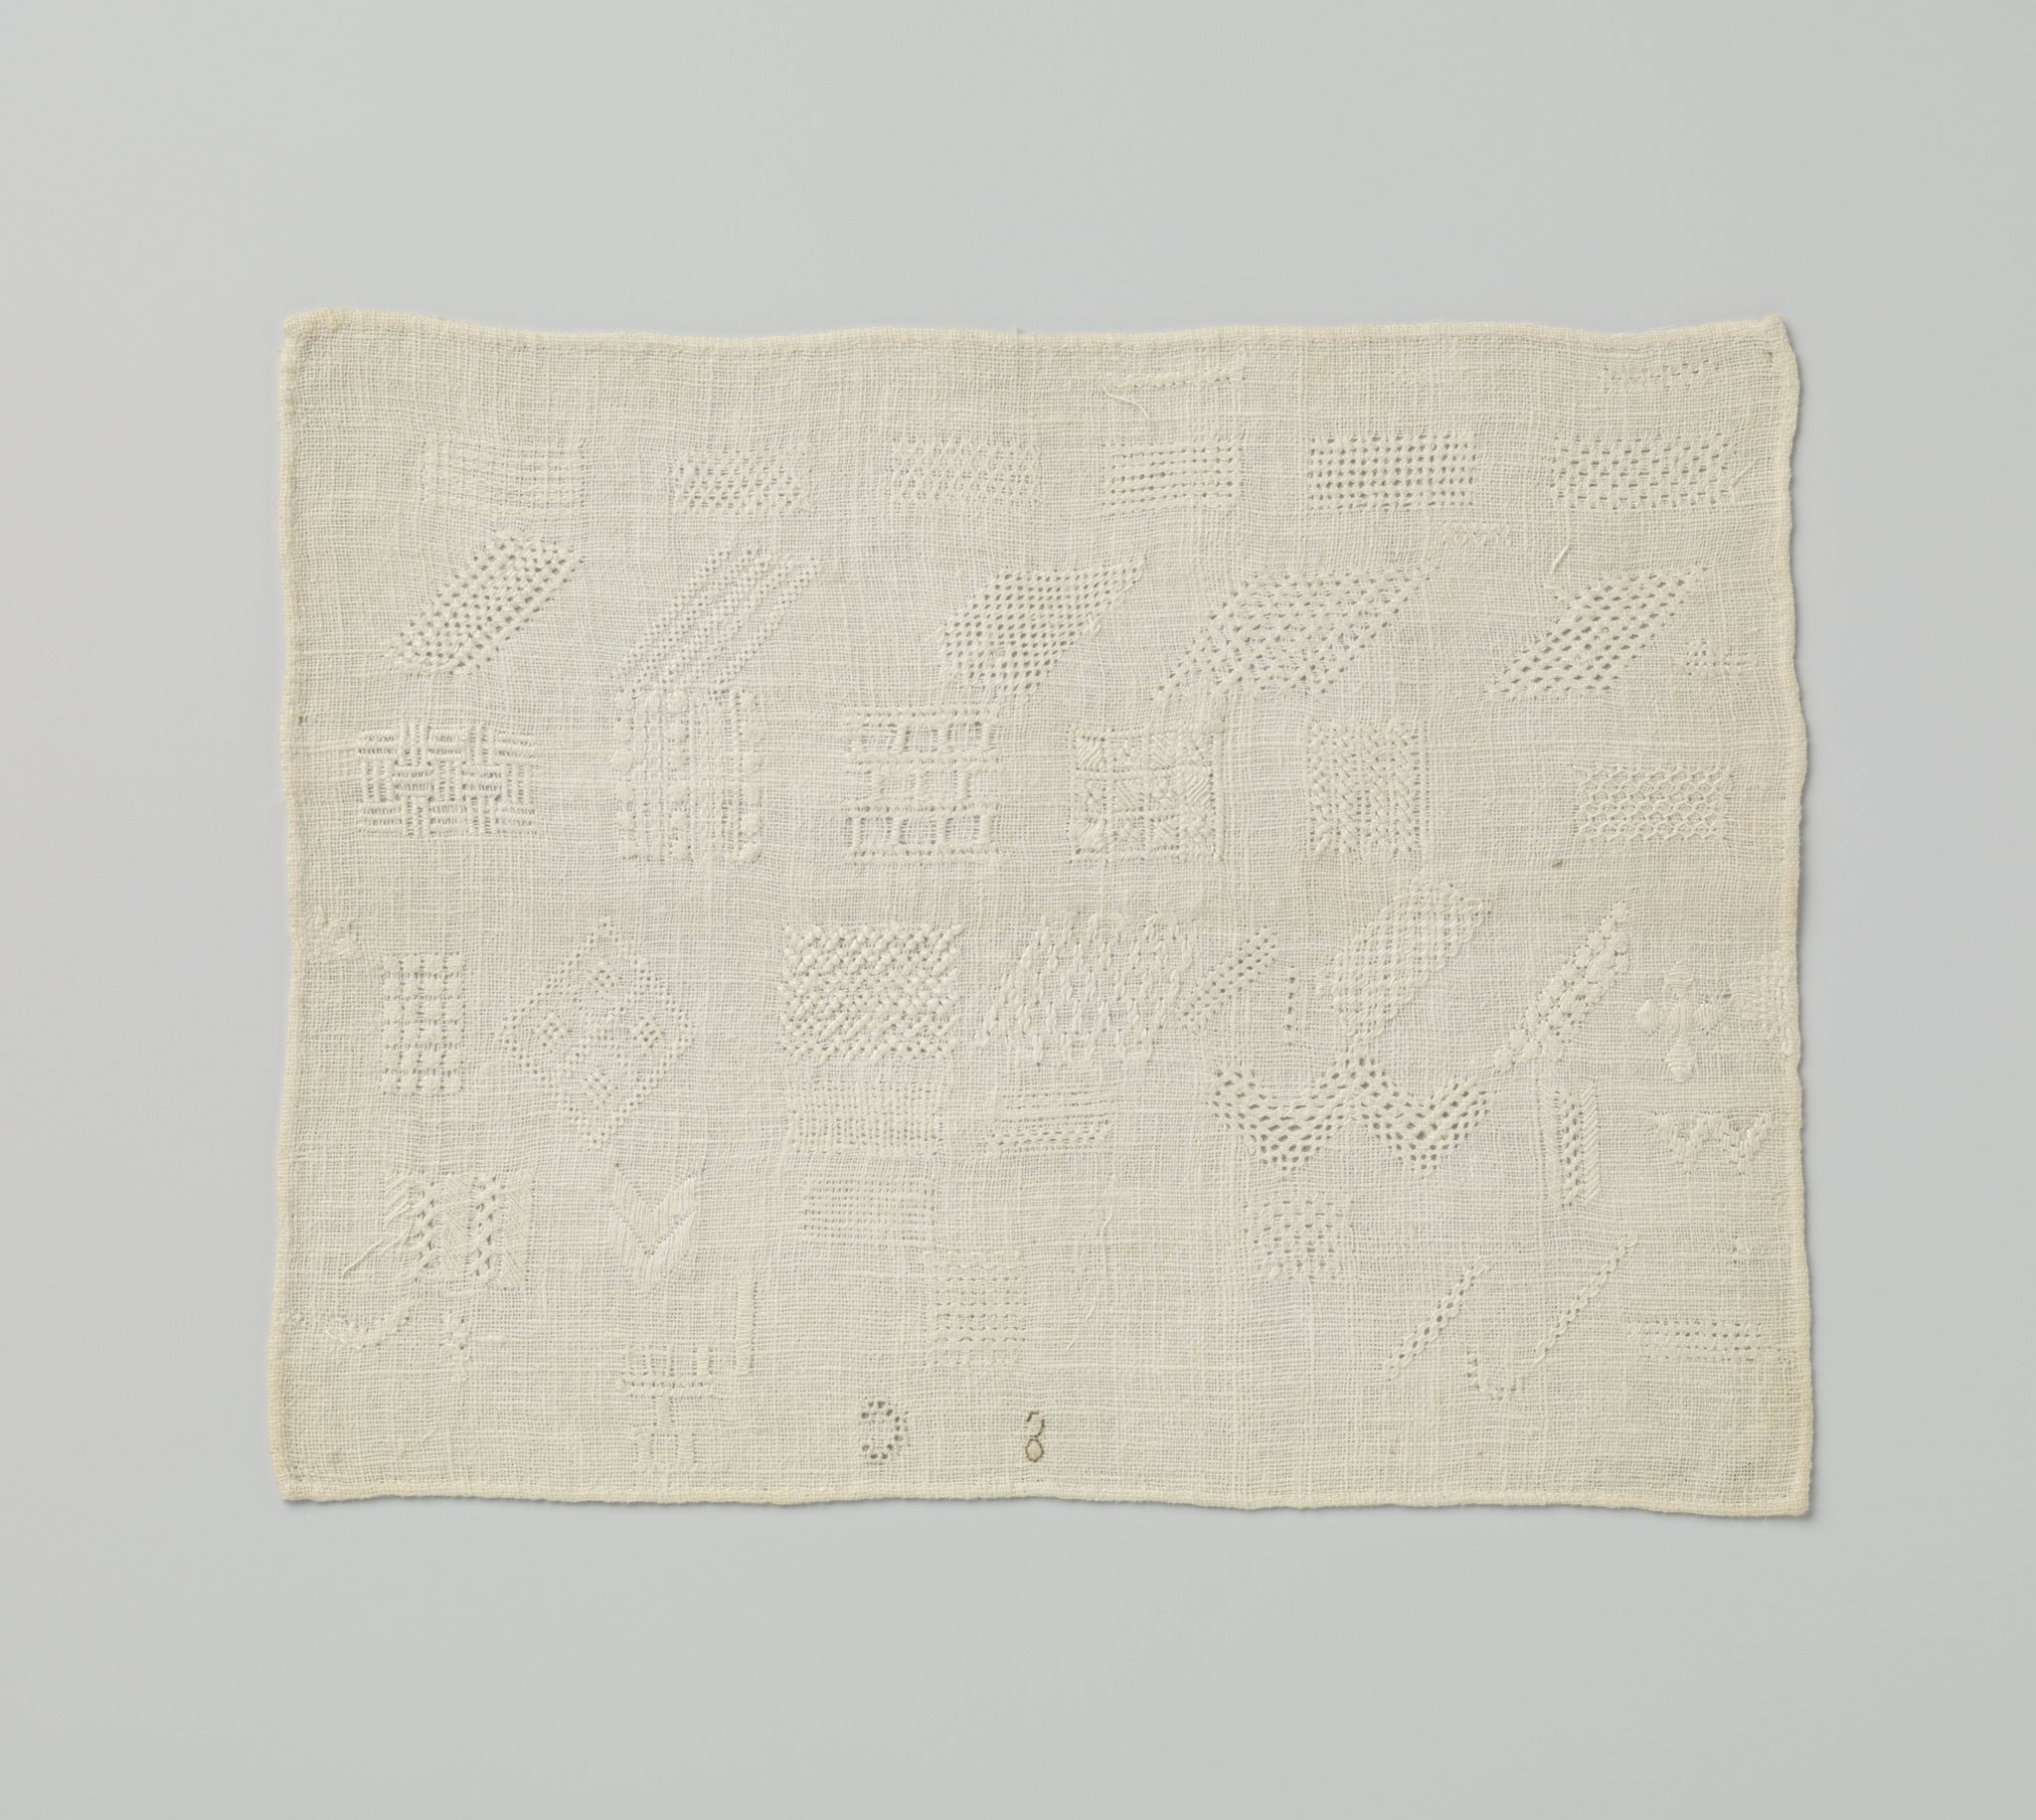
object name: borduurlap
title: Borduurlap met rijen steken.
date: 1750-1800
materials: cotton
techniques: embroidered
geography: netherlands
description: Borduurlap van katoen, met rijen proefsteken en de letter C.